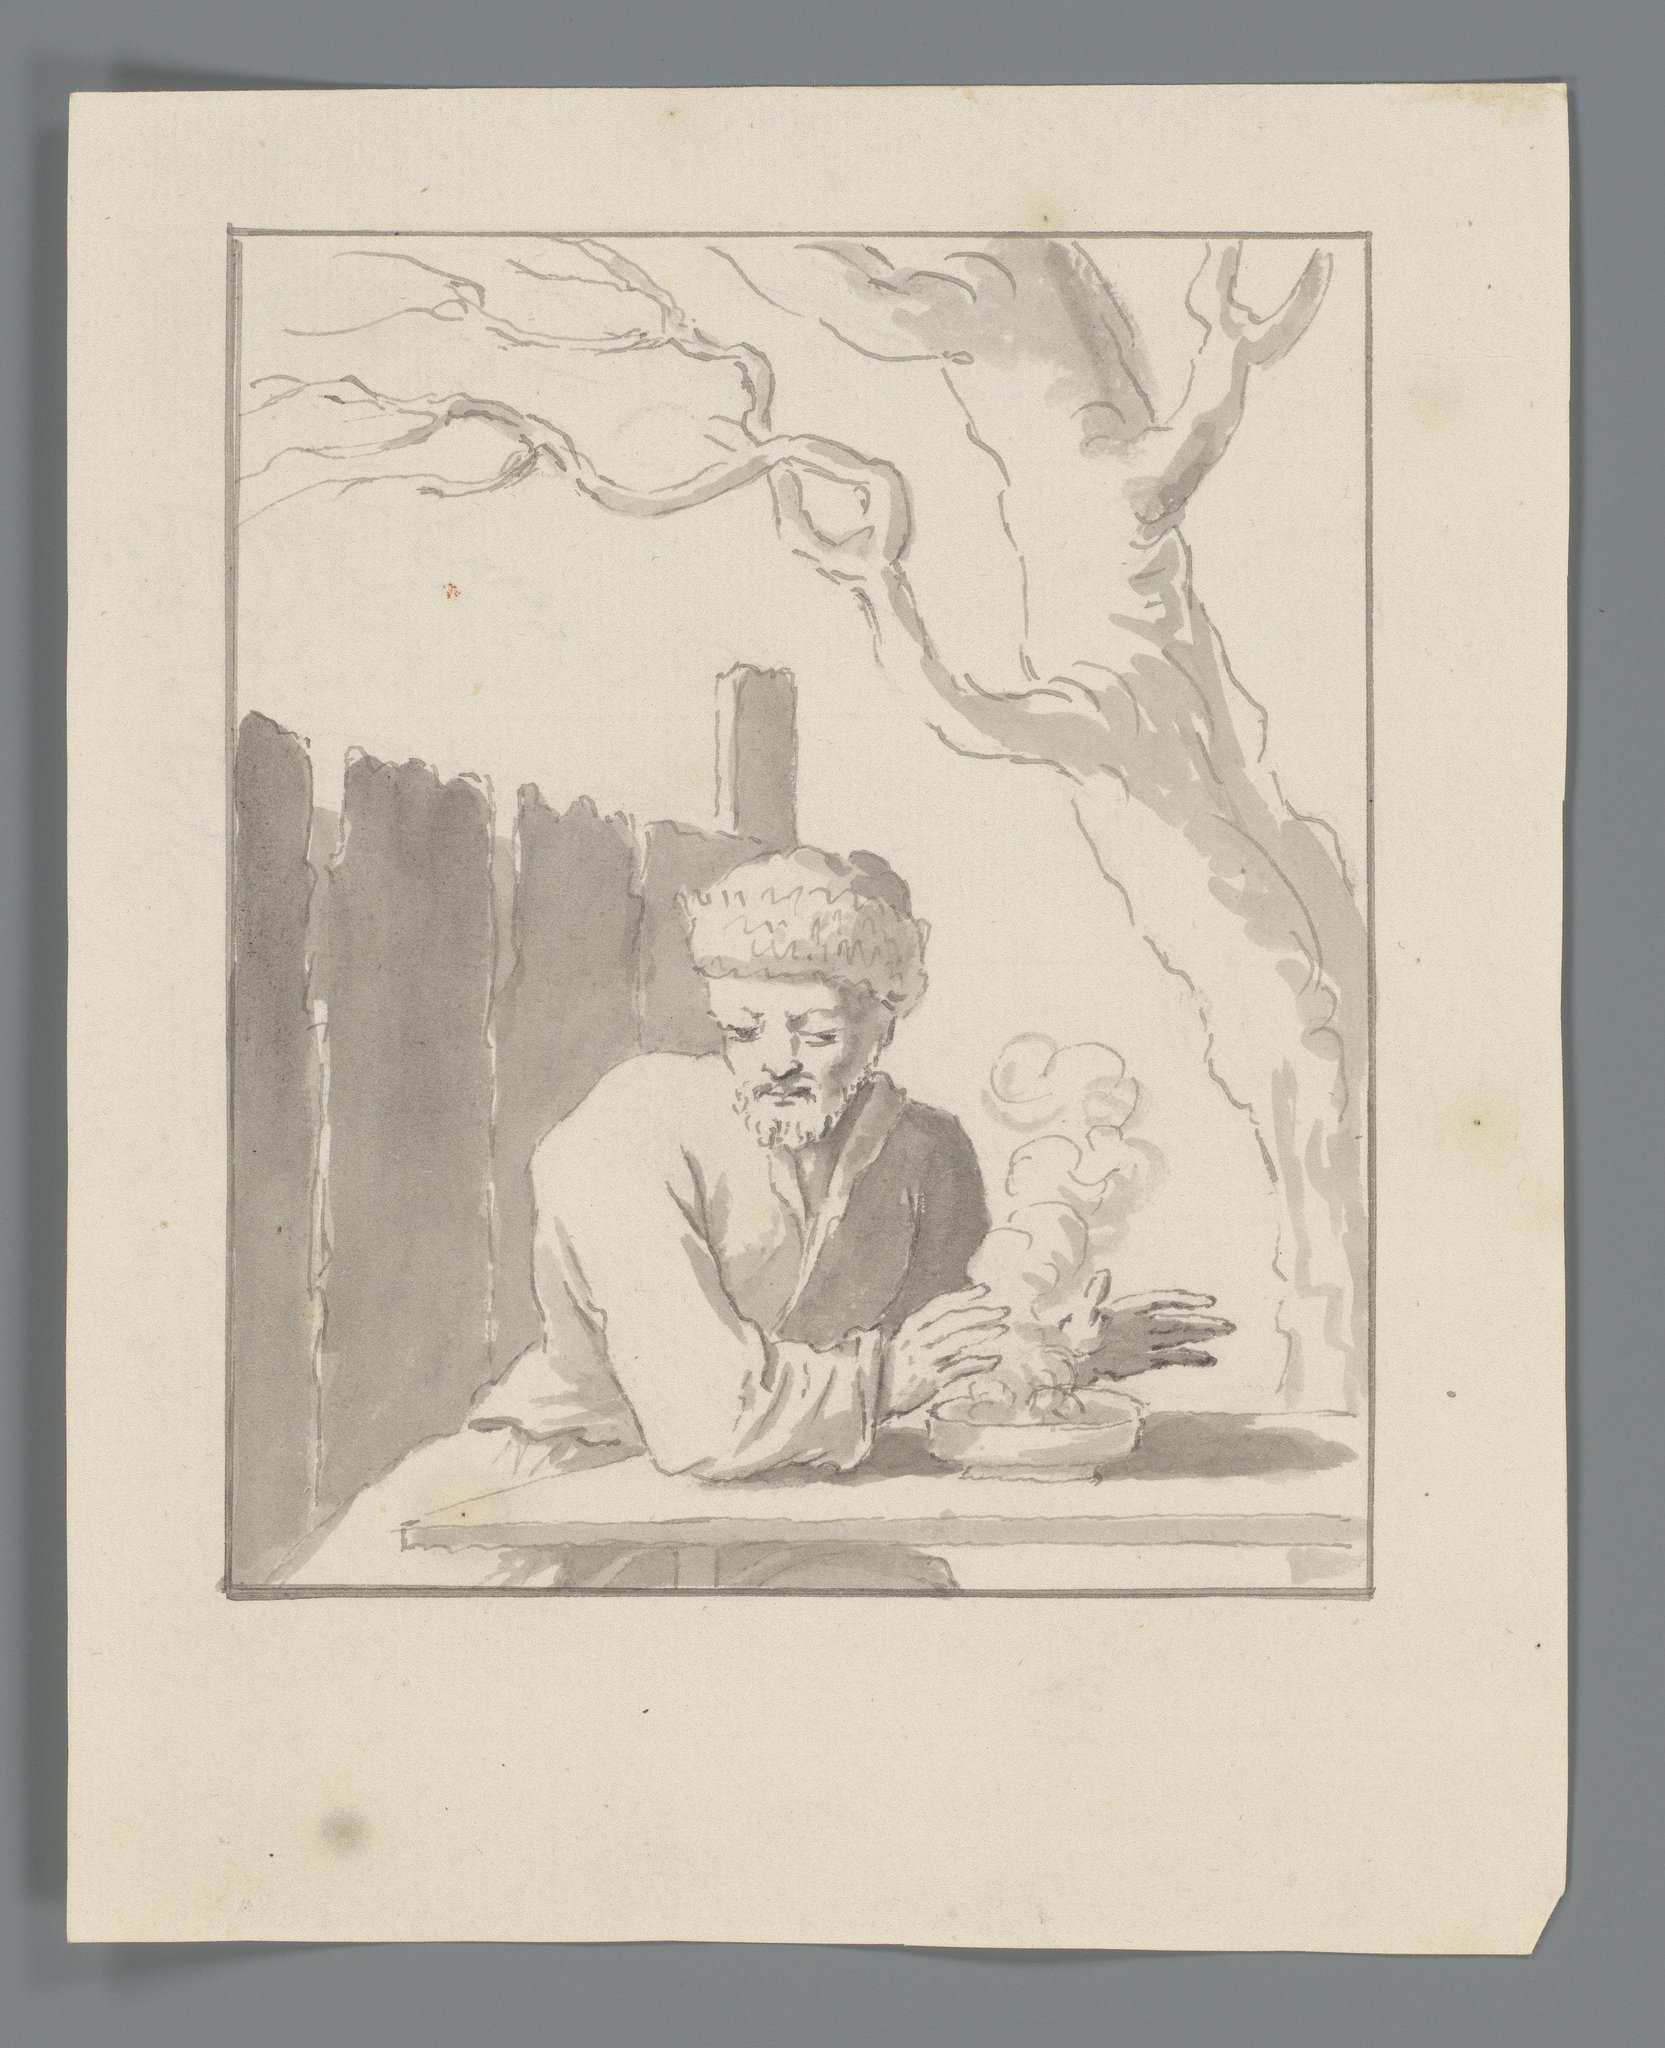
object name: drawing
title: Man met muts warmt zijn handen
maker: matthijs balen (1684-1766)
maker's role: draughtsman, painter, print maker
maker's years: 1684-1766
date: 1694-1766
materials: paper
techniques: brush, pen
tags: warming oneself at a fire (or hearth, stove, fire-pan, brazier)